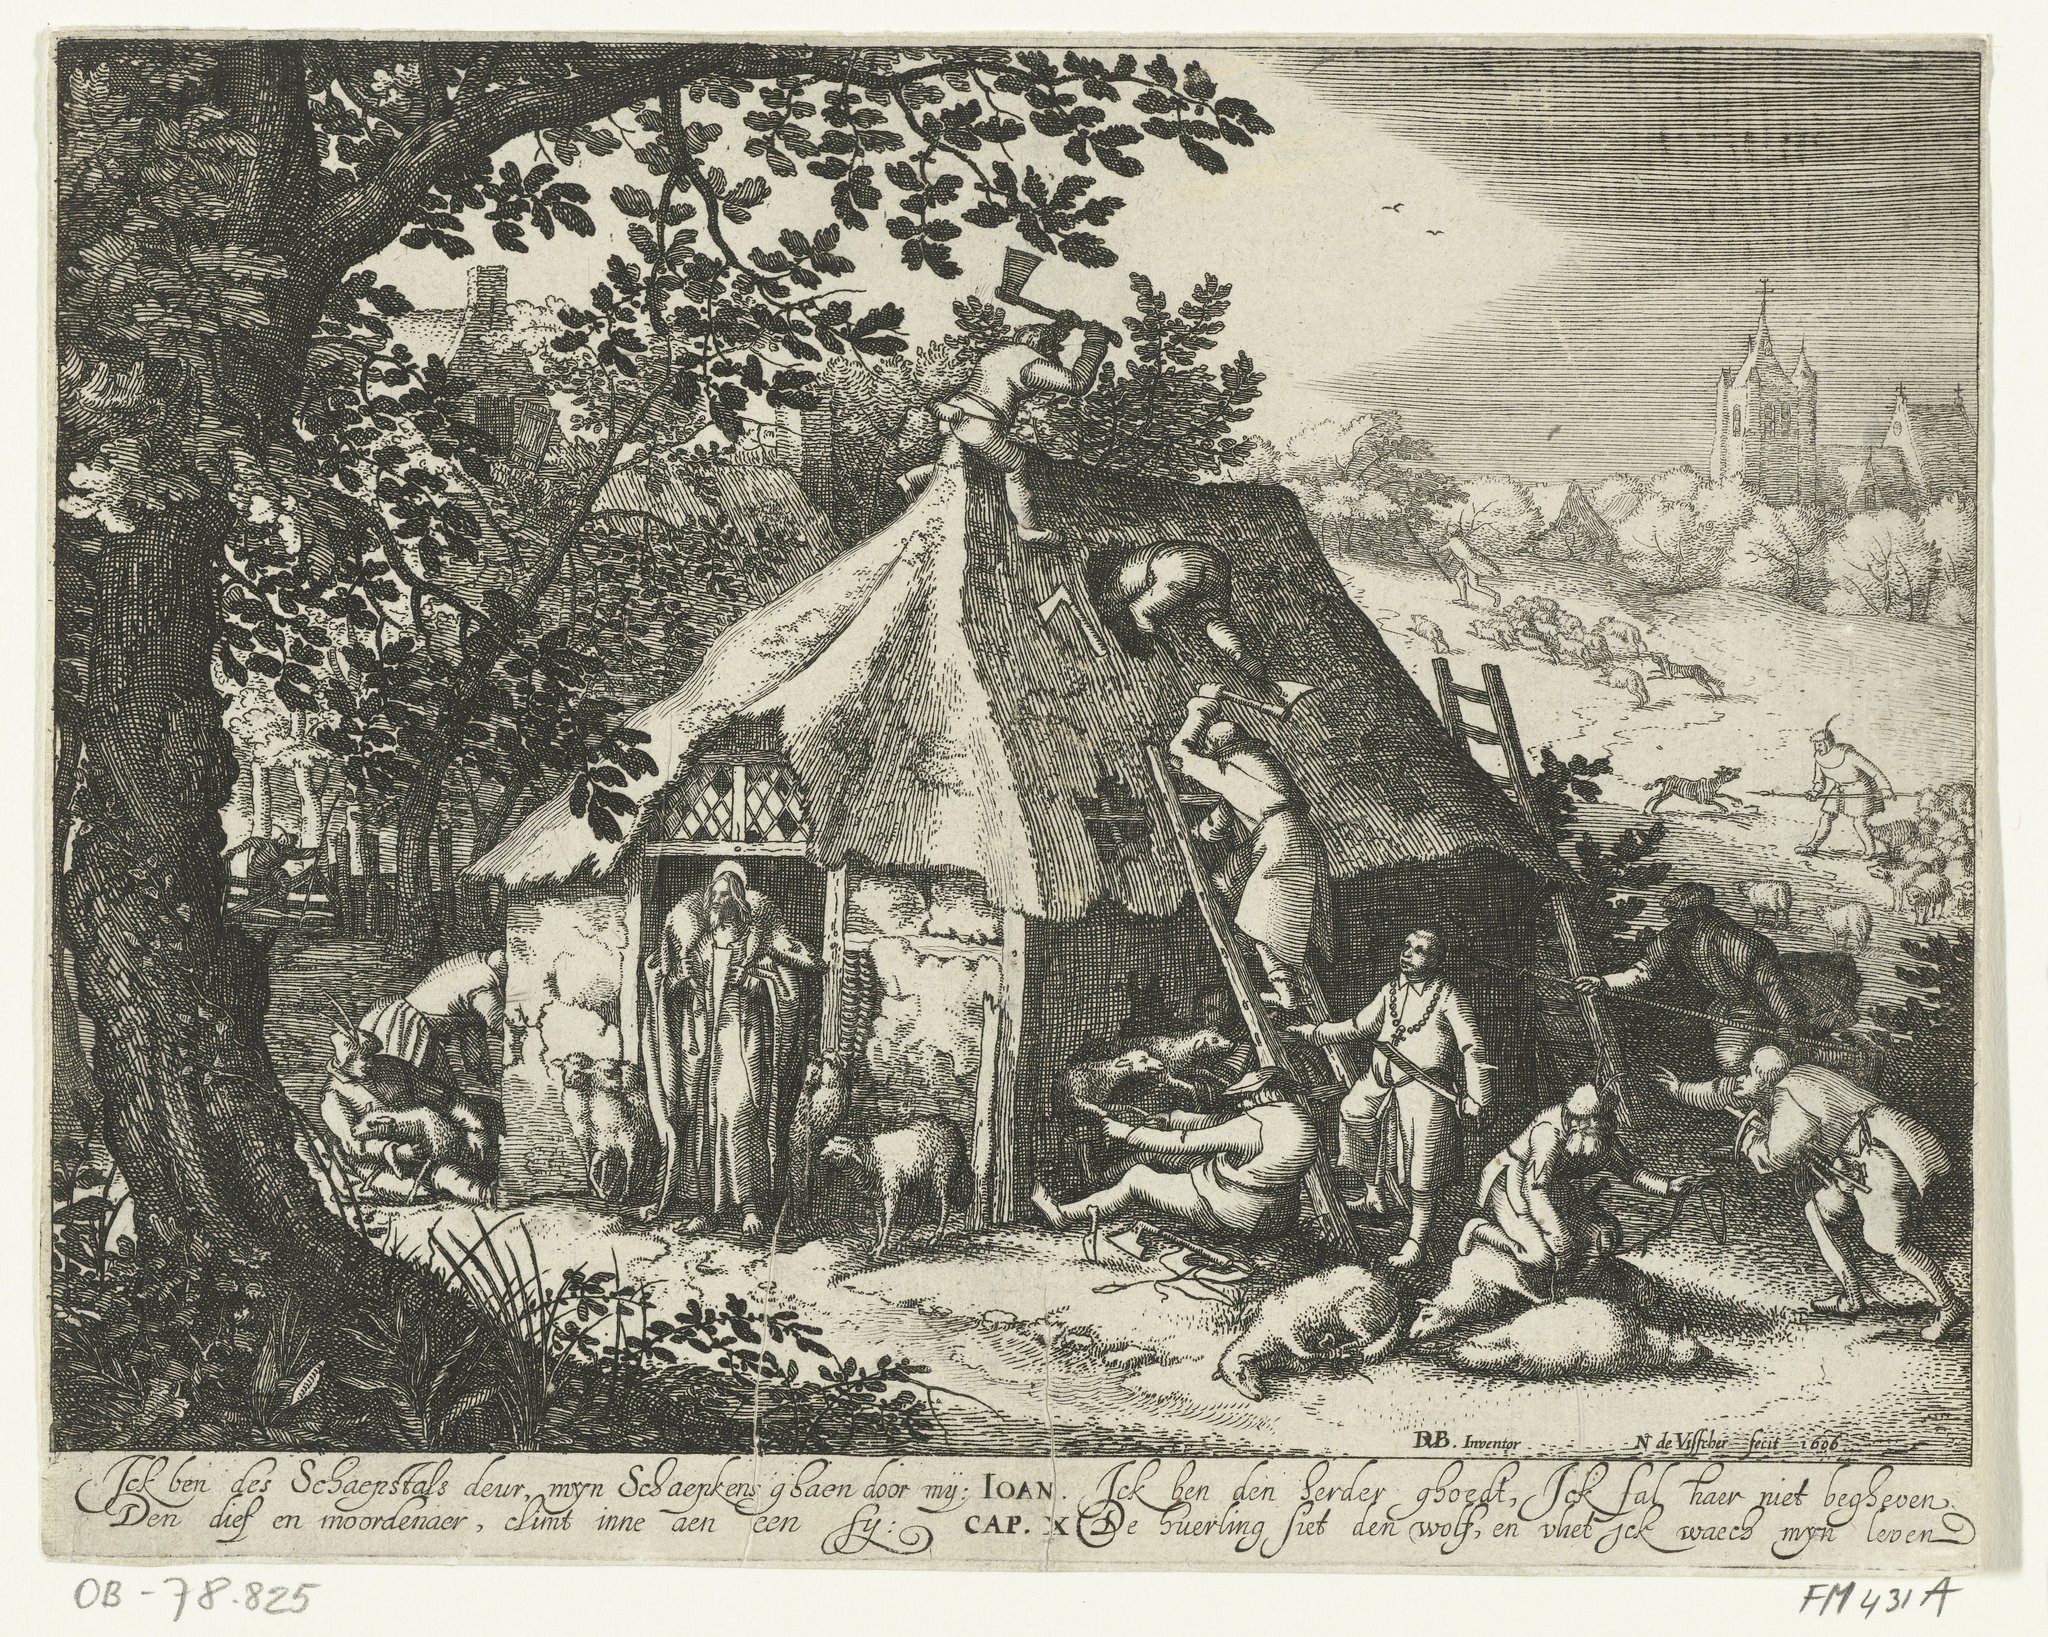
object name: print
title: Christus bij de schaapskooi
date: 1606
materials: paper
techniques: engraving, etching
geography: amsterdam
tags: 'i am the door of the sheep' ~ parable of the good shepherd, christ as good shepherd, 'thieves and robbers' climb on the roof of the sheepfold ~ parable of the good shepherd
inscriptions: date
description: Christus bij de schaapskooi als de Goede Herder, ca. 1560. Christus staande in de deur naar de schaapstal met een lam op de schouders. Via de zijmuren en het dak proberen dieven binnen te dringen en schapen uit de stal te stelen. Op de achtergrond verjaagt een herder een wolf van zijn kudde. Met onderschrift van 2 keer 2 regels in het Nederlands en een verwijzing naar Johannes 10. Spotprent op de Roomse Kerk, thematiek van ca. 1560.